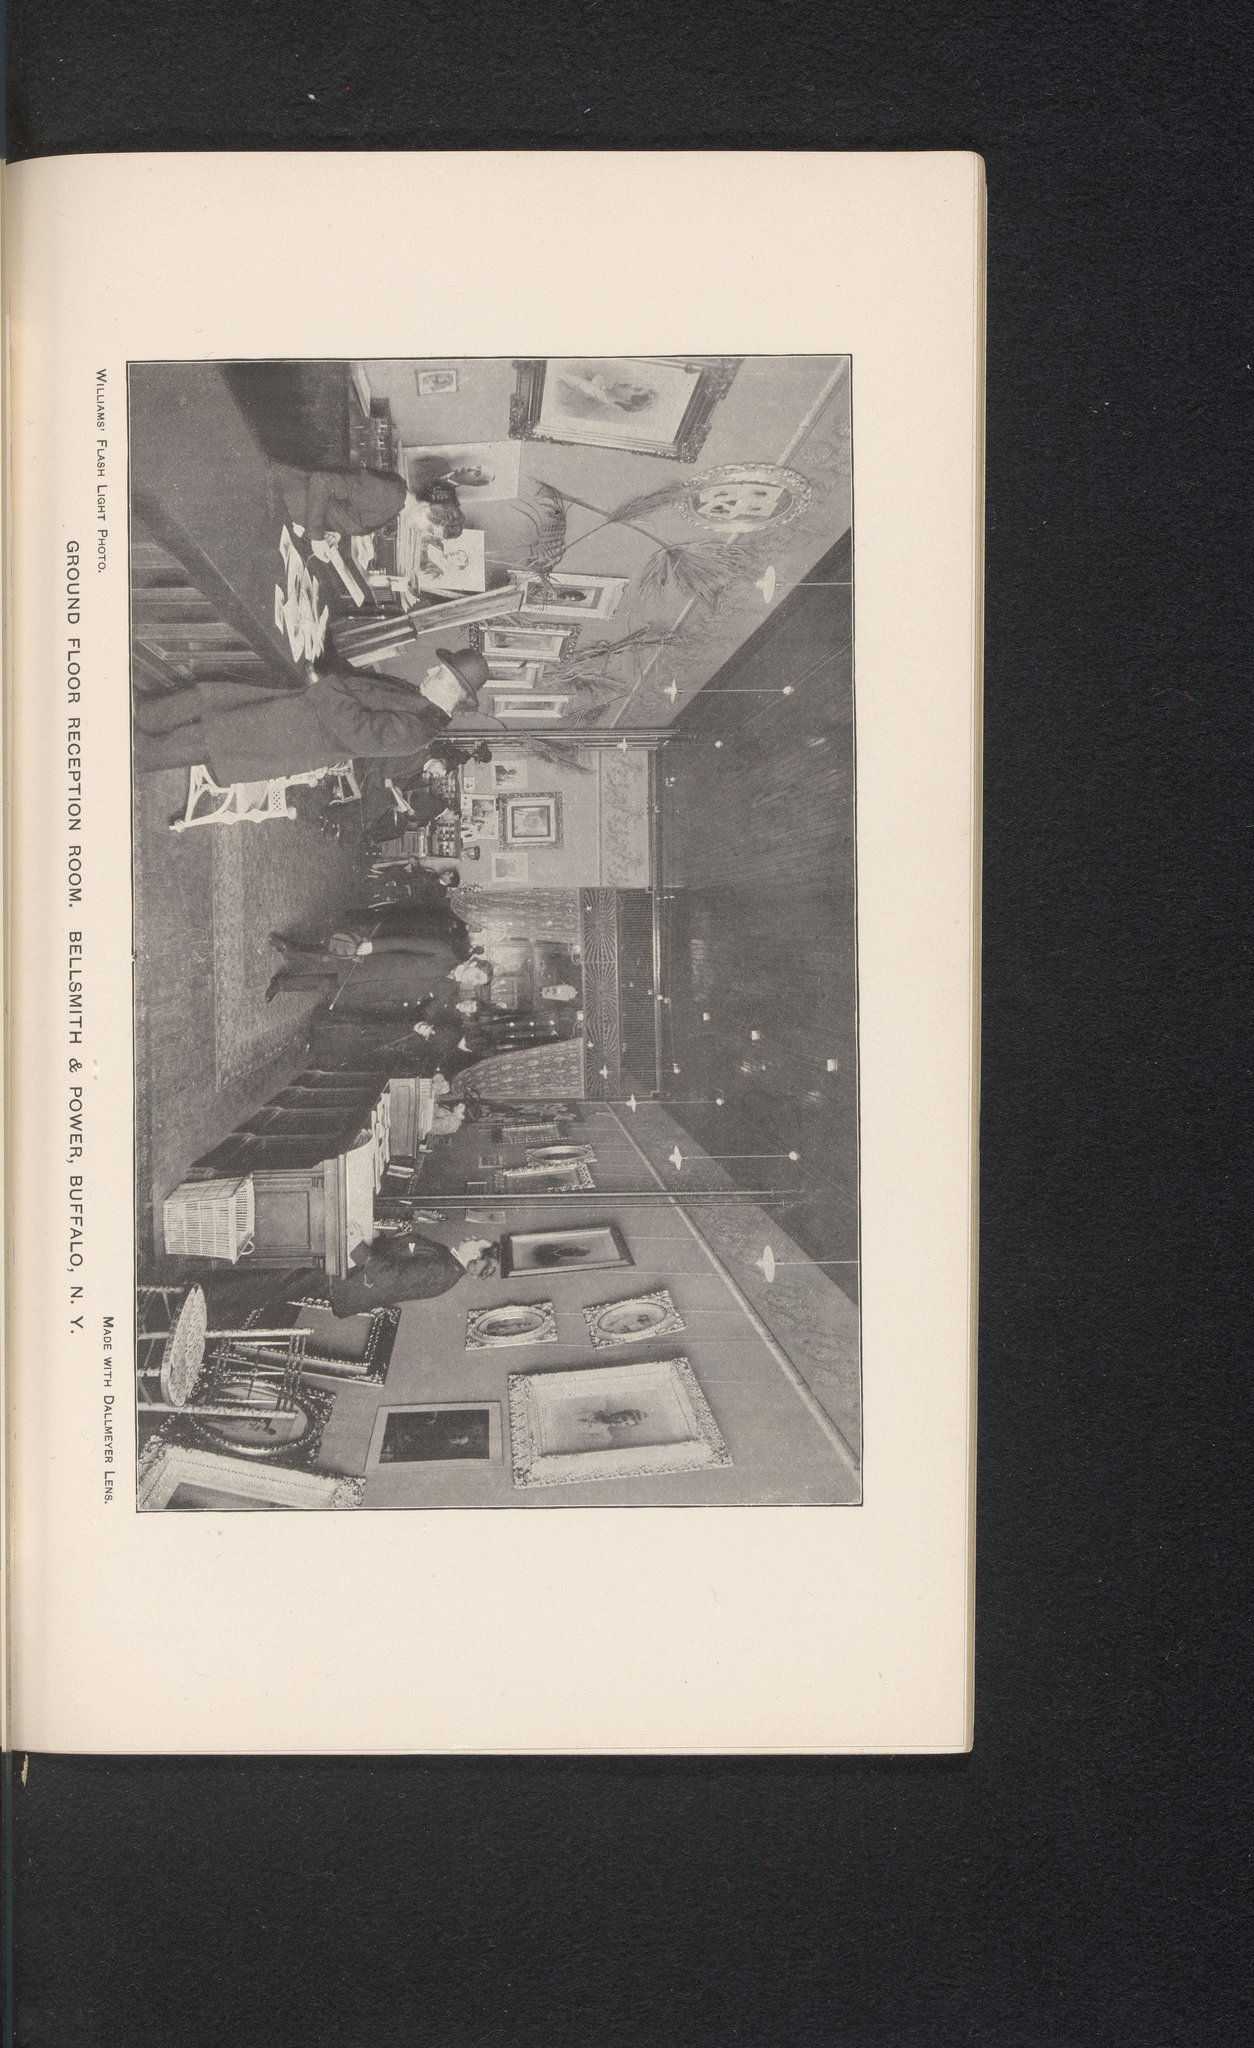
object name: page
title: Receptie van een gebouw met onbekende mensen en verschillende portretten aan de muur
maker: Anonymous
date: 1888-1893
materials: paper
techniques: autotype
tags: reception desk (~ hotel), historical persons, frame of painting, etc.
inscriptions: inscription: ‘Williams' flash light photo. Made with Dallmeyer Lens.’, inscription: ‘Bellsmith & Power, Buffalo, N.Y.’